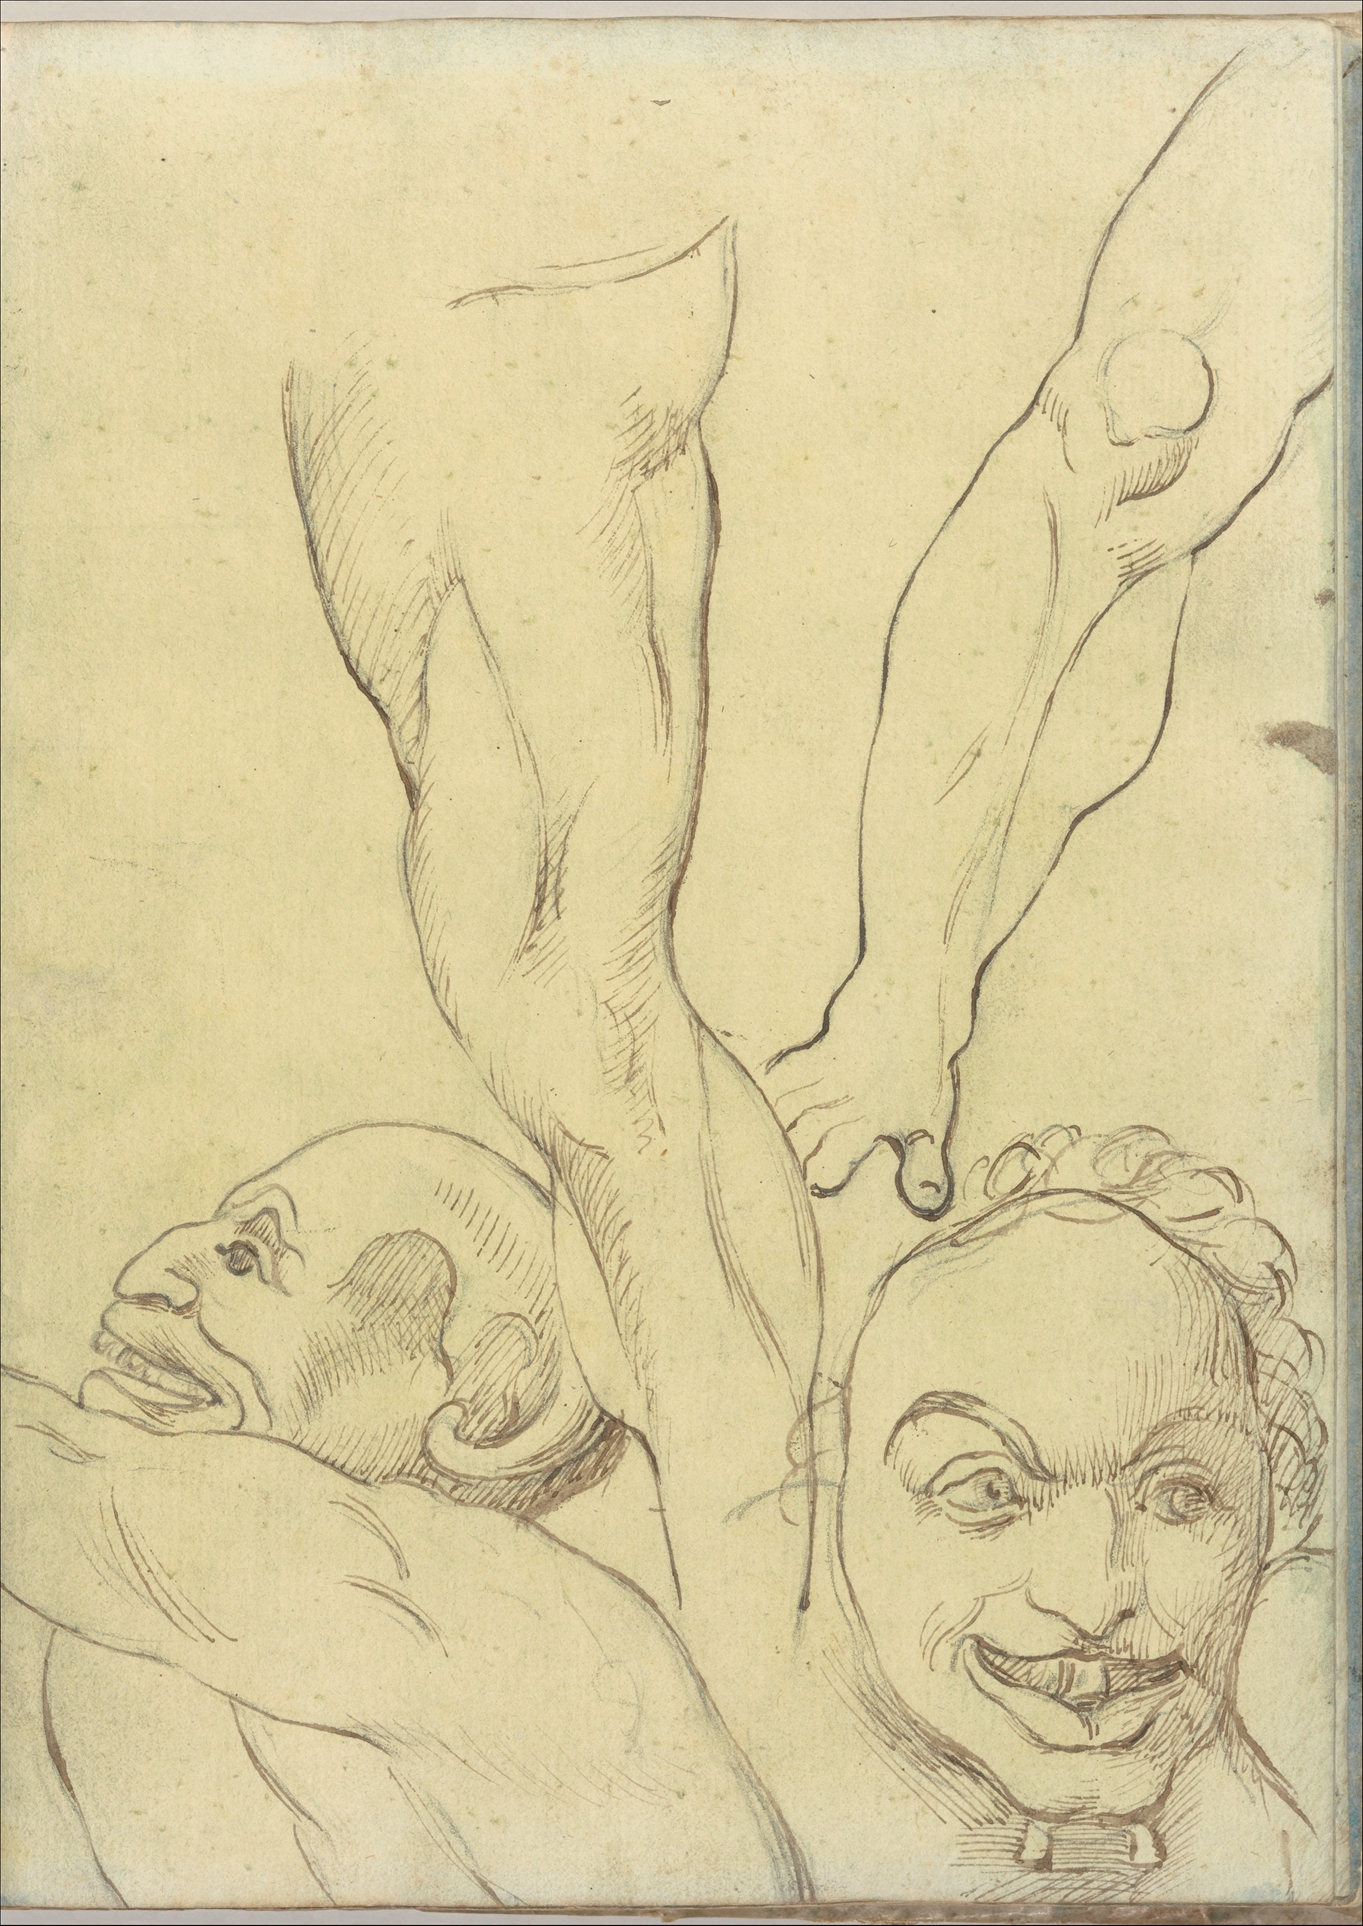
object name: drawing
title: Two demons and two legs, after Michelangelo (?) (Smaller Italian sketchbook, leaf 16 recto)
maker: joseph wright (wright of derby)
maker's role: artist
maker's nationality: british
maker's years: 1734-1797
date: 1774-1775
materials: graphite, ink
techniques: brush, pen, wash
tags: demons